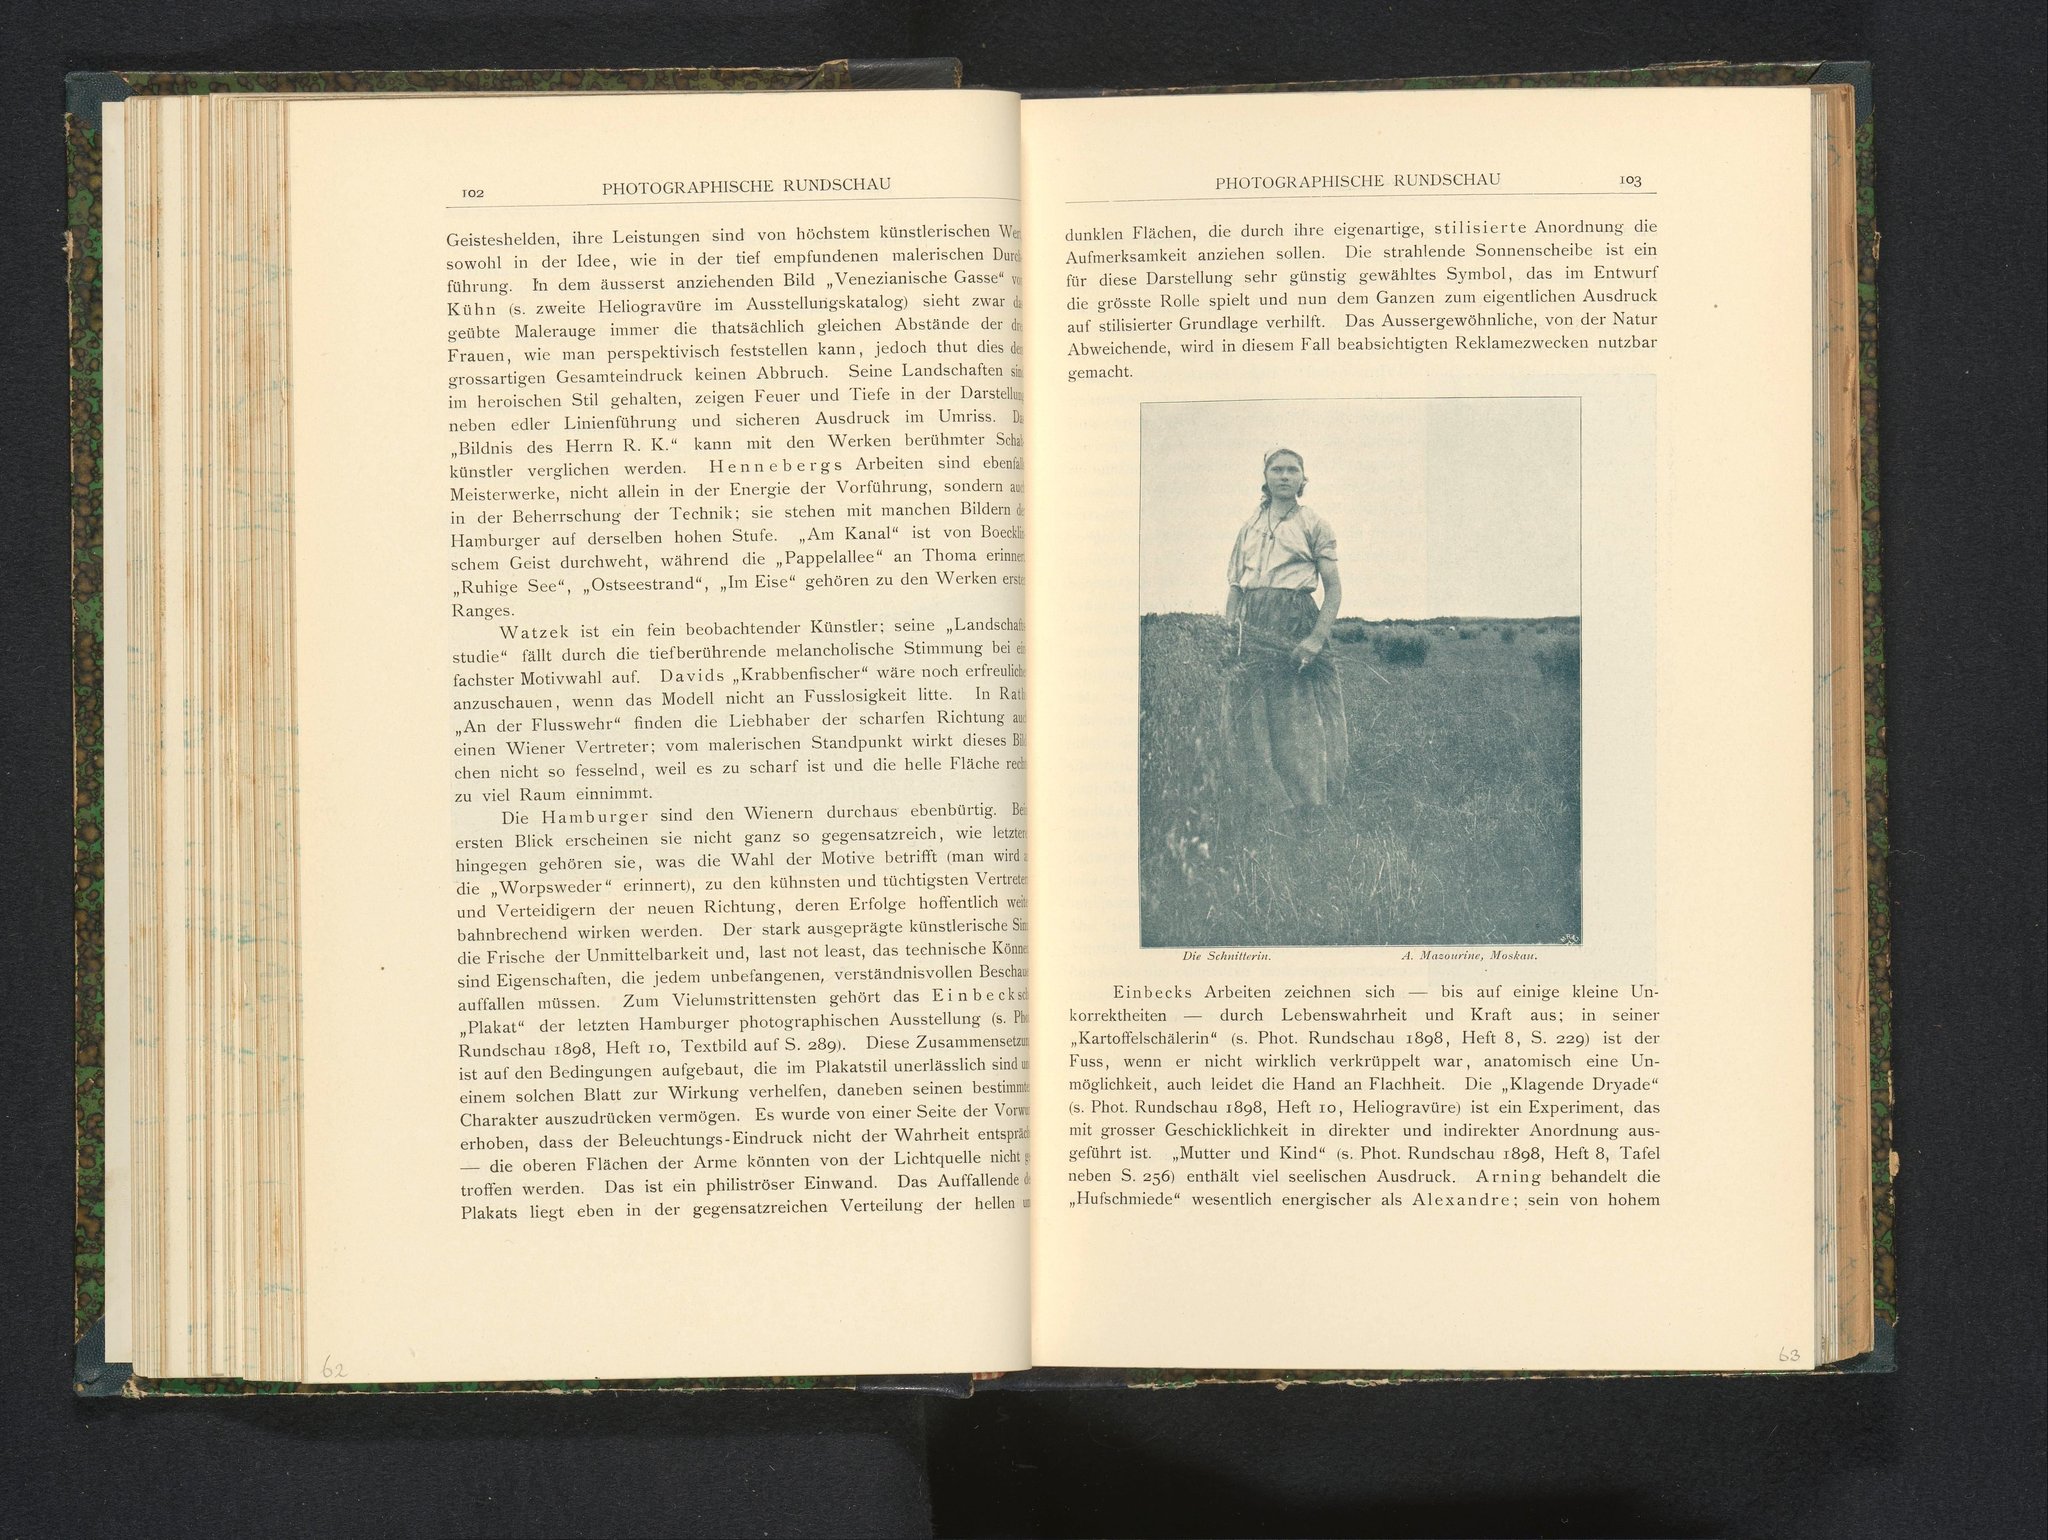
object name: page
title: Portret van een onbekende maaier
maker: alexis mazourine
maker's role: fotograaf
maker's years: 1846-1918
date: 1894-1899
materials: paper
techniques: autotype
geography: berlin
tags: historical persons not known by name - bb - woman, reaping, picking, mowing ~ harvest